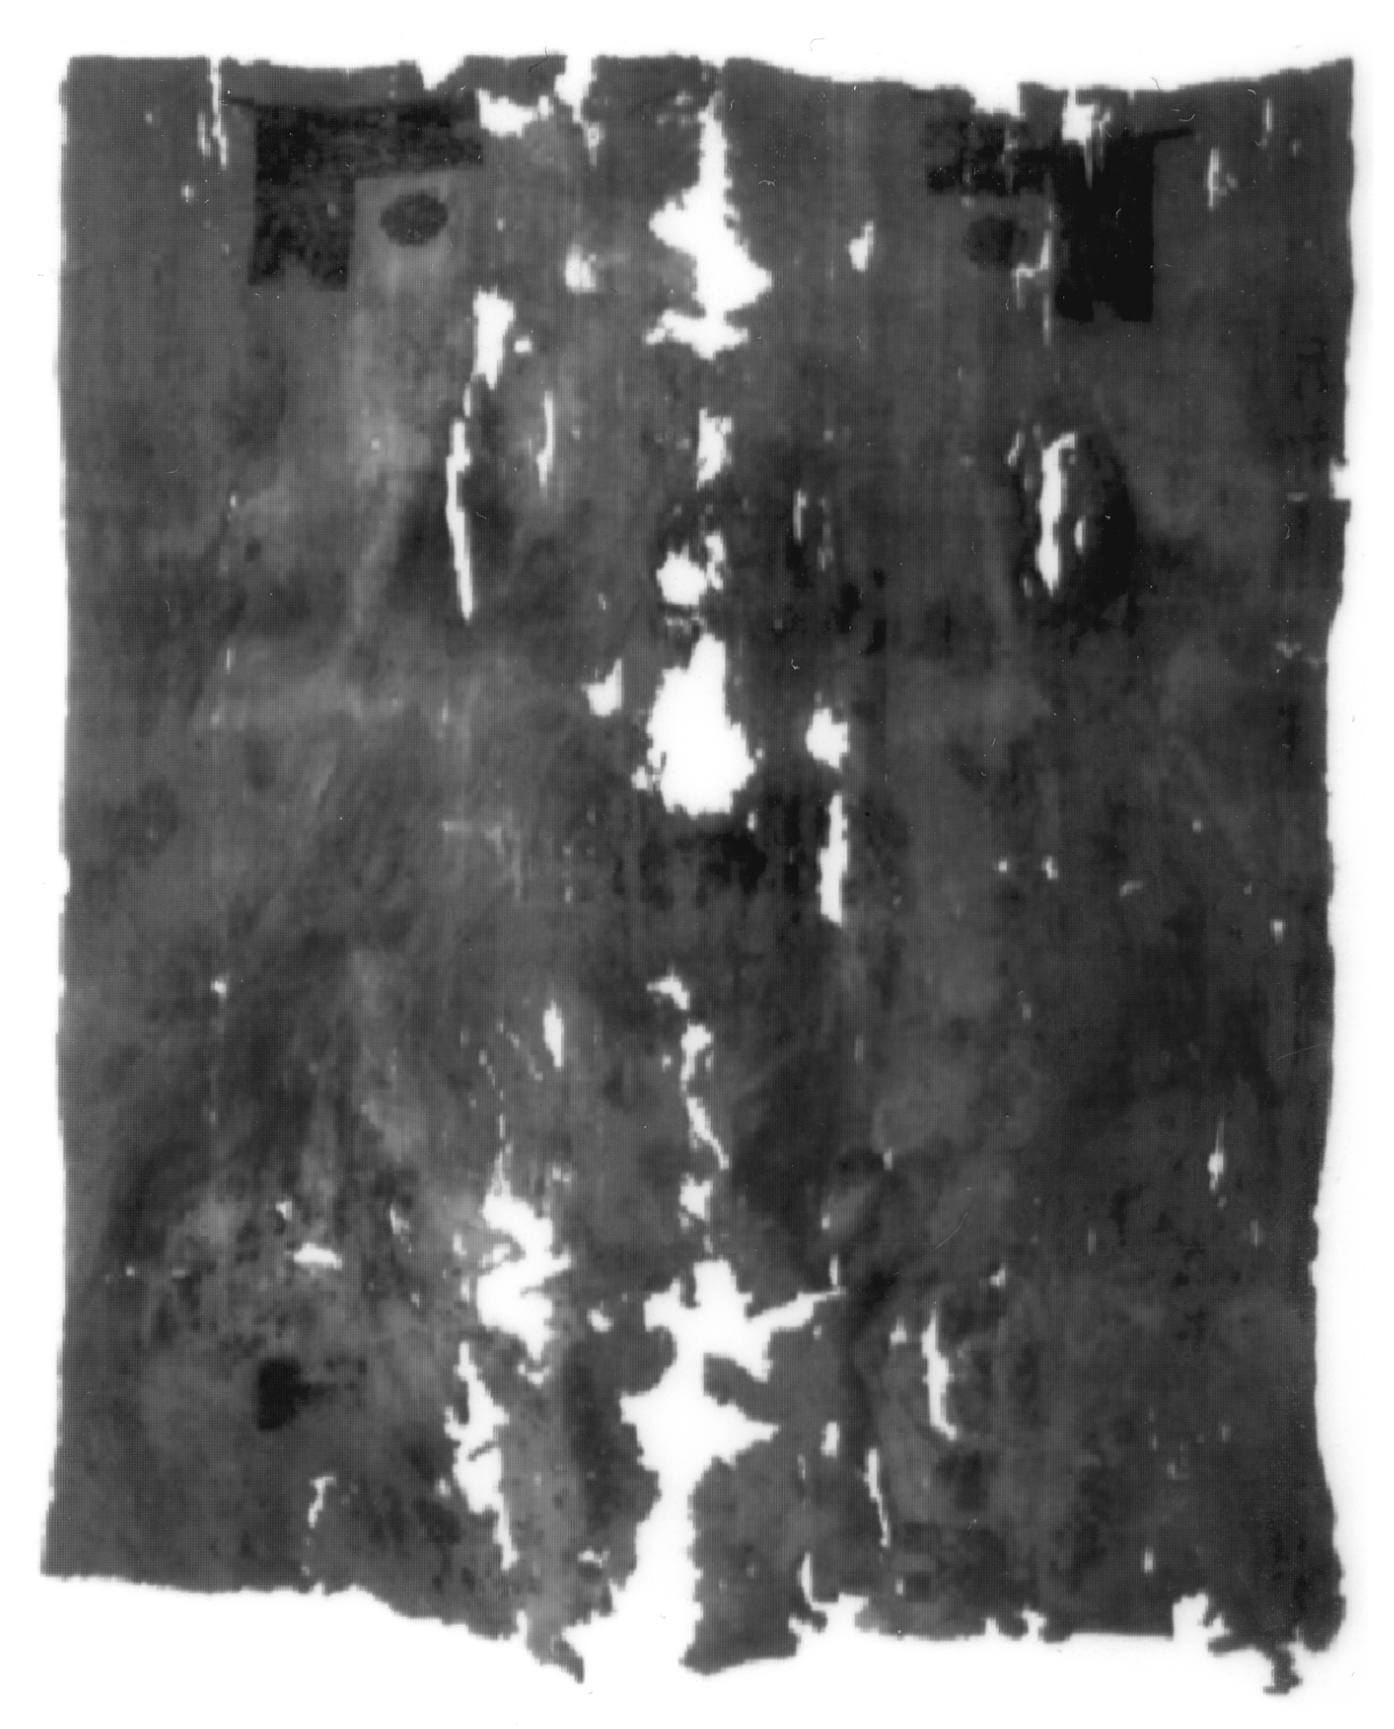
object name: sheet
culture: coptic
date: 301-400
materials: linen, wool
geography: egypt